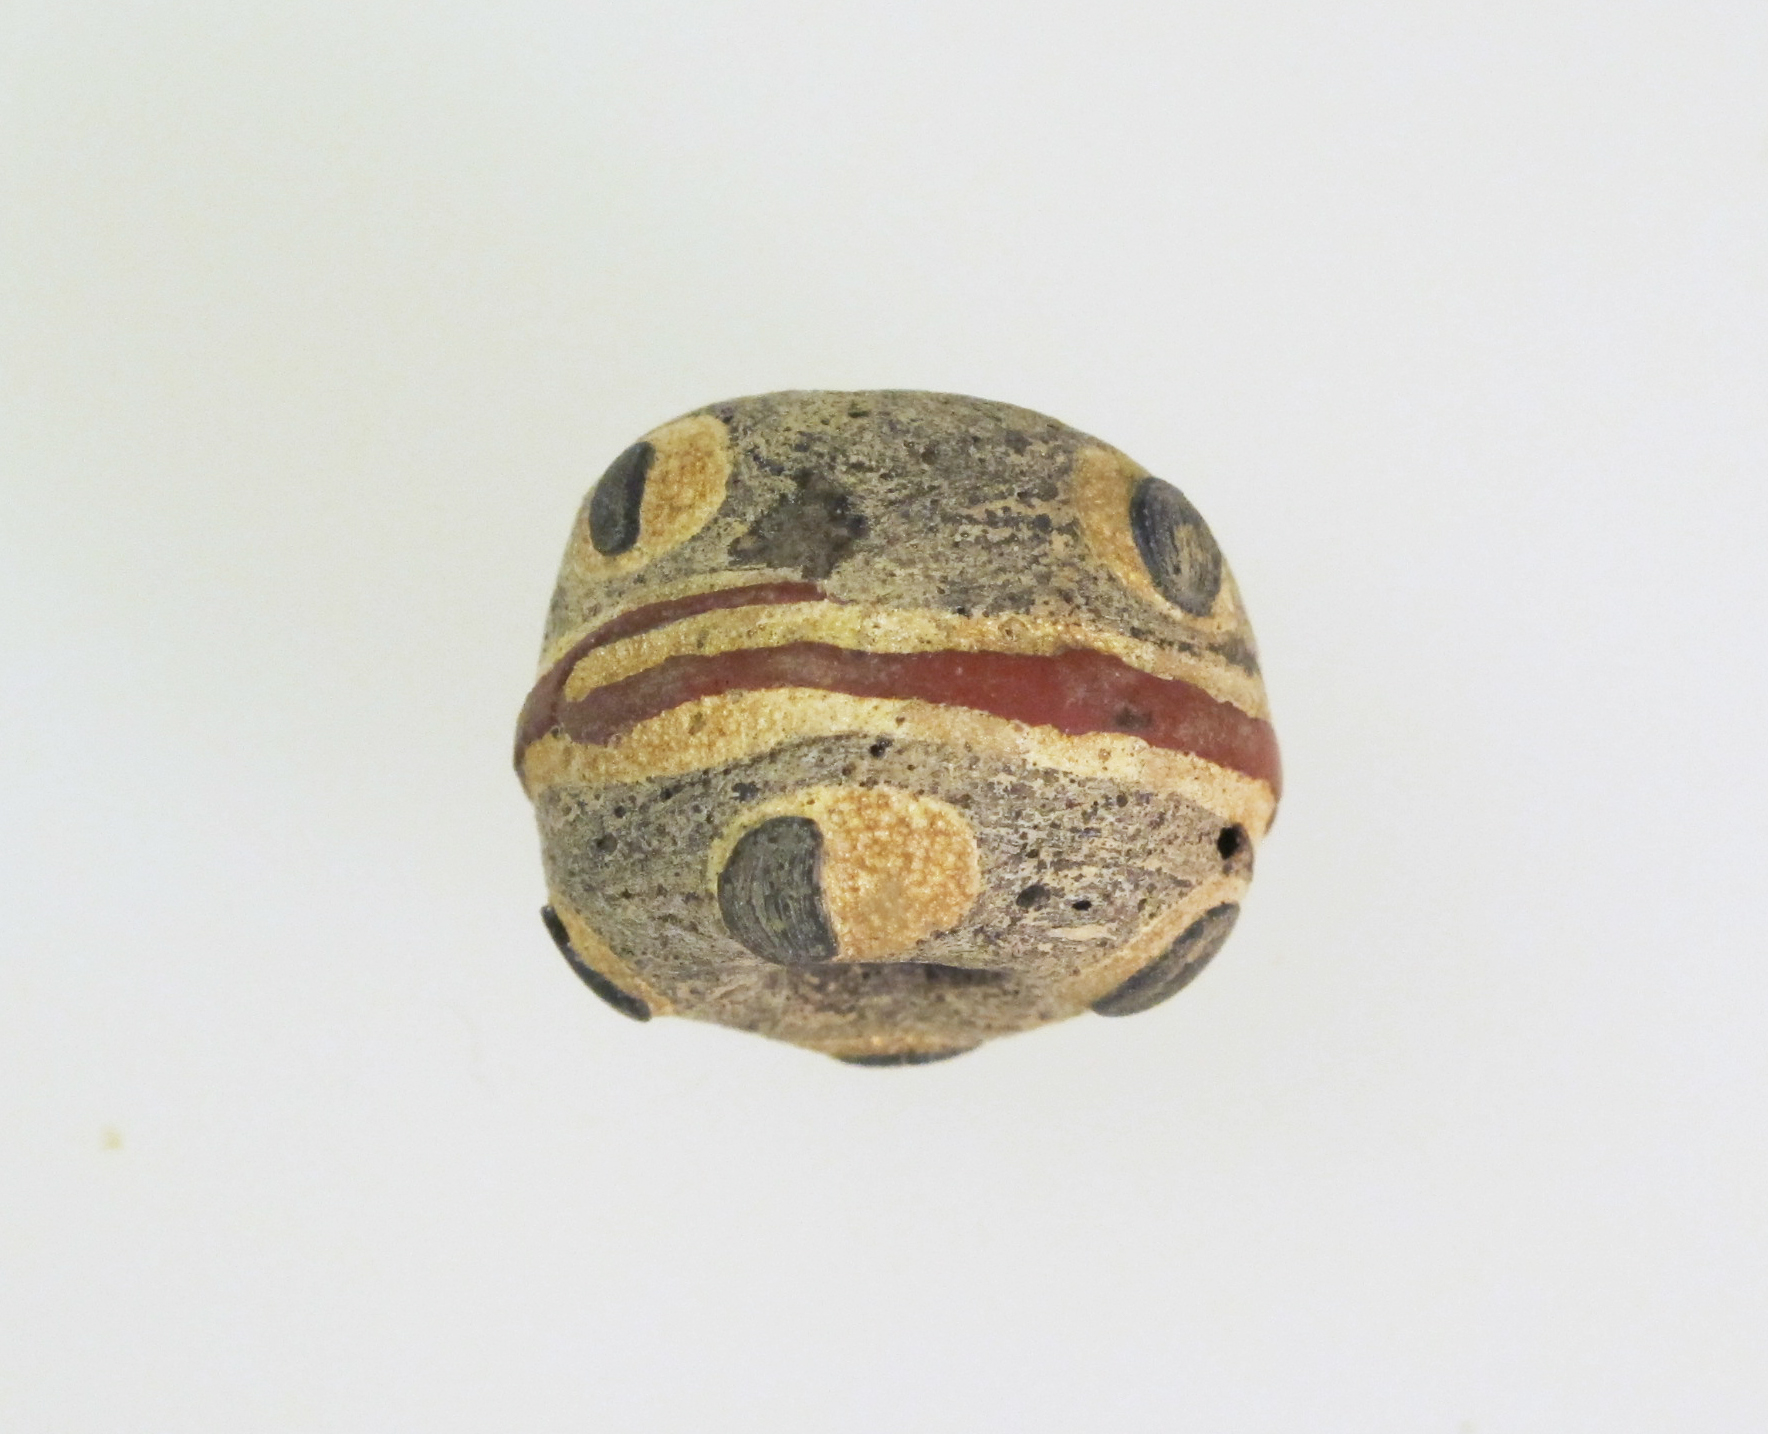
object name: bead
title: Glass bead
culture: carthaginian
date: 367-335 BCE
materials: glass